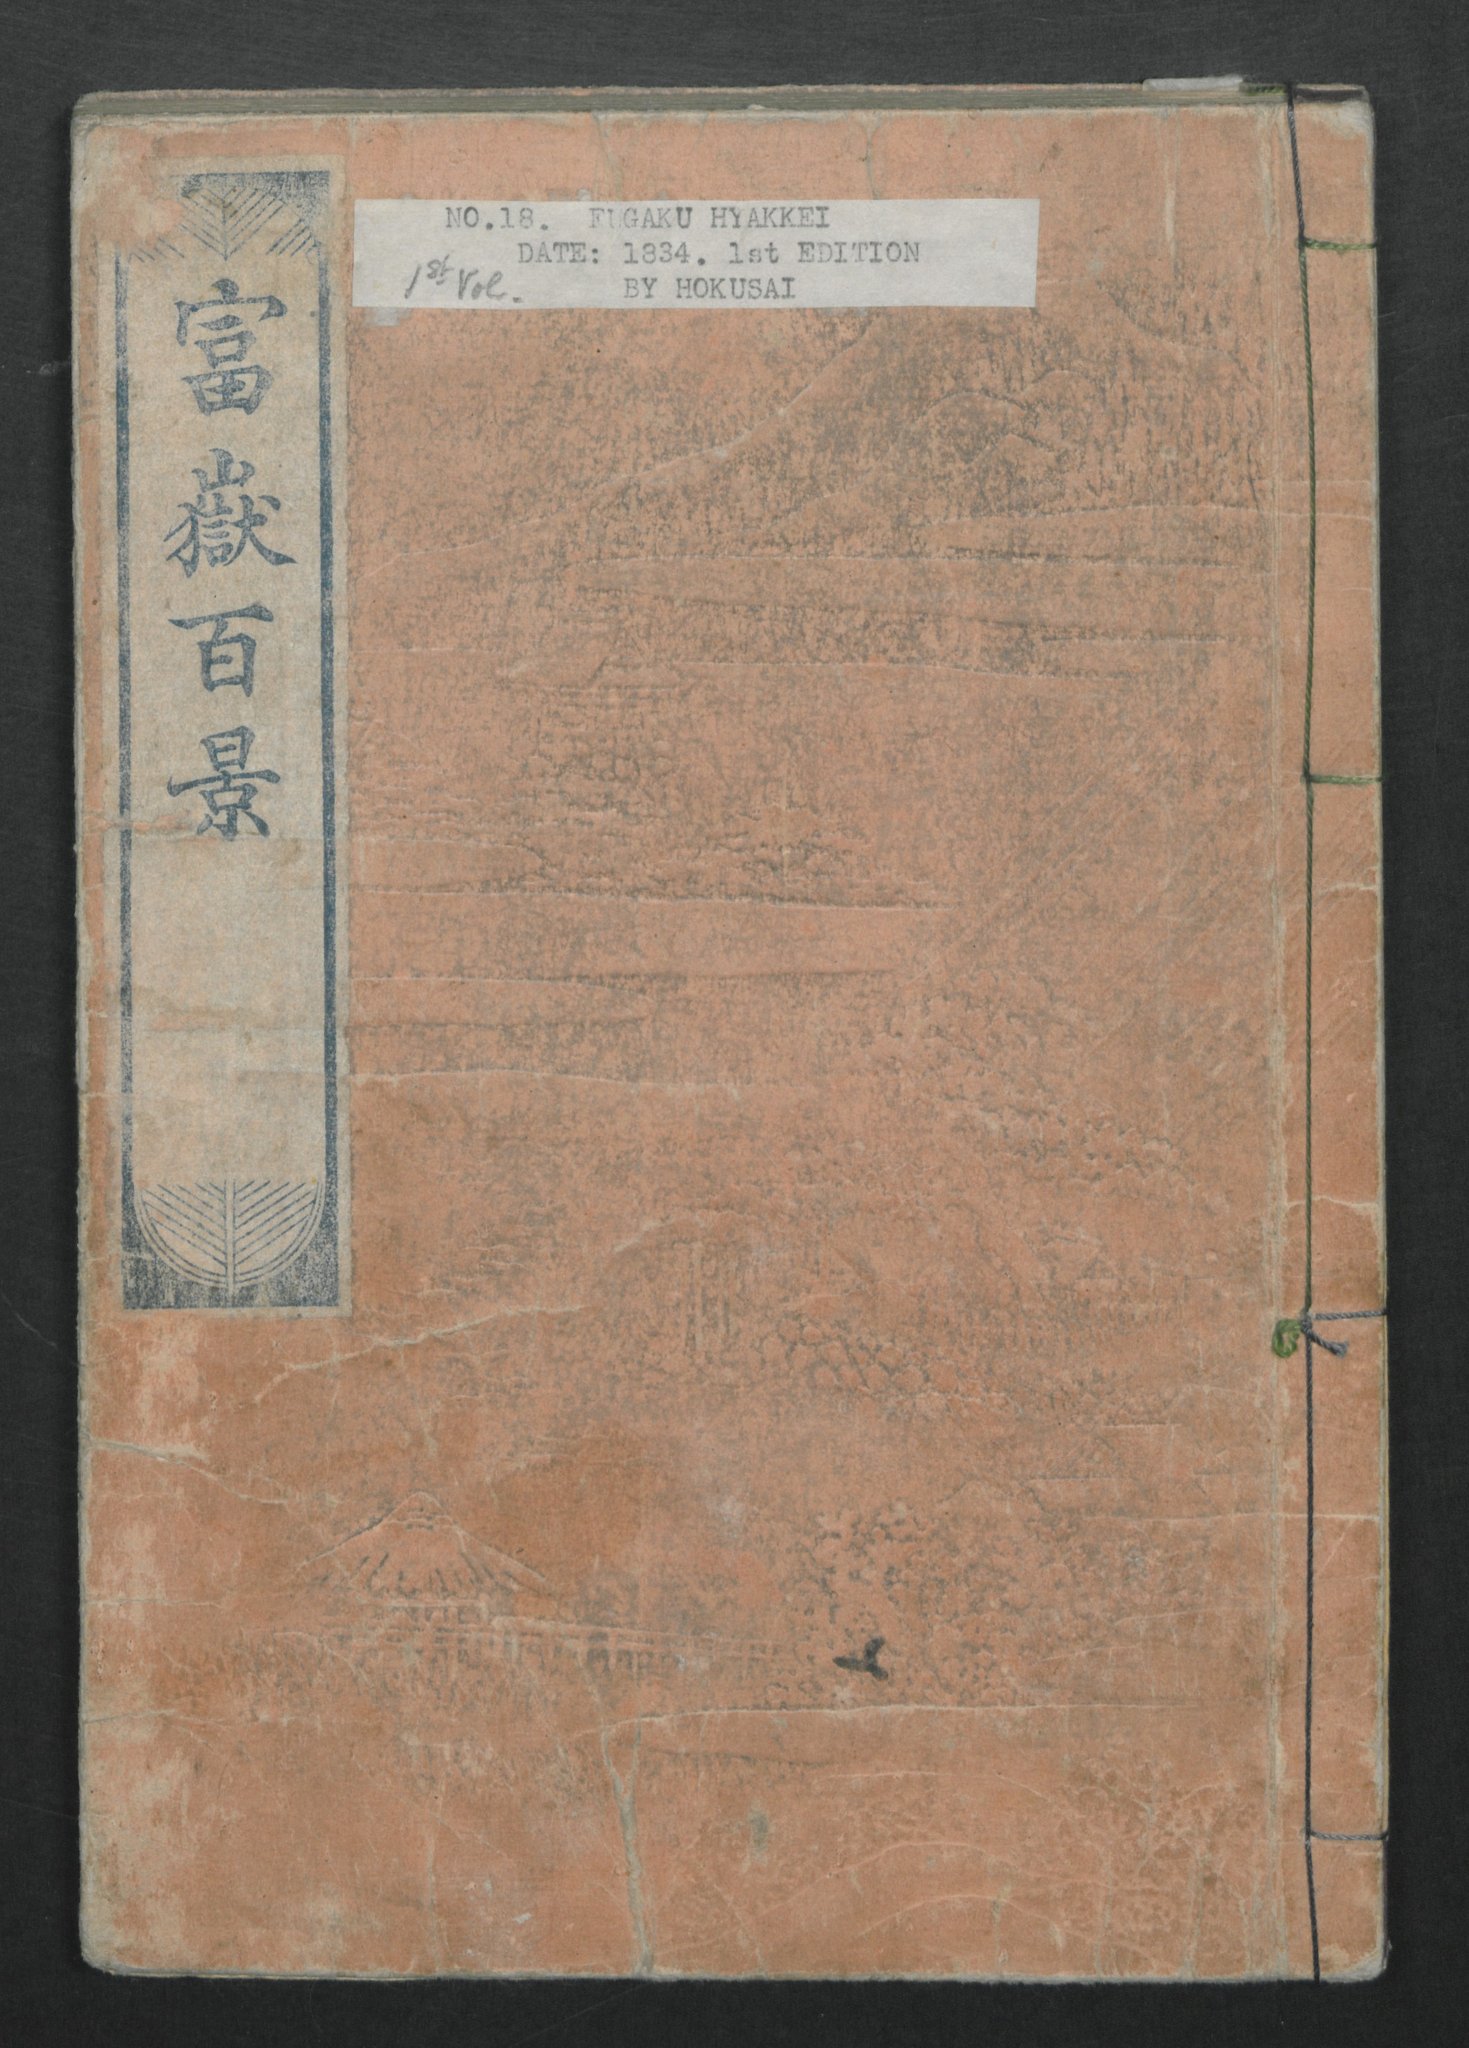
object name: illustrated book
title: One Hundred Views of Mount Fuji (Fugaku Hyakkei shohen) 富嶽百景 初編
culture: japanese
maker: katsushika hokusai 葛飾北斎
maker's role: artist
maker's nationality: japanese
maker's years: 1760-1849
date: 1834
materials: ink, paper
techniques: woodblock print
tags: men,mountains,trees